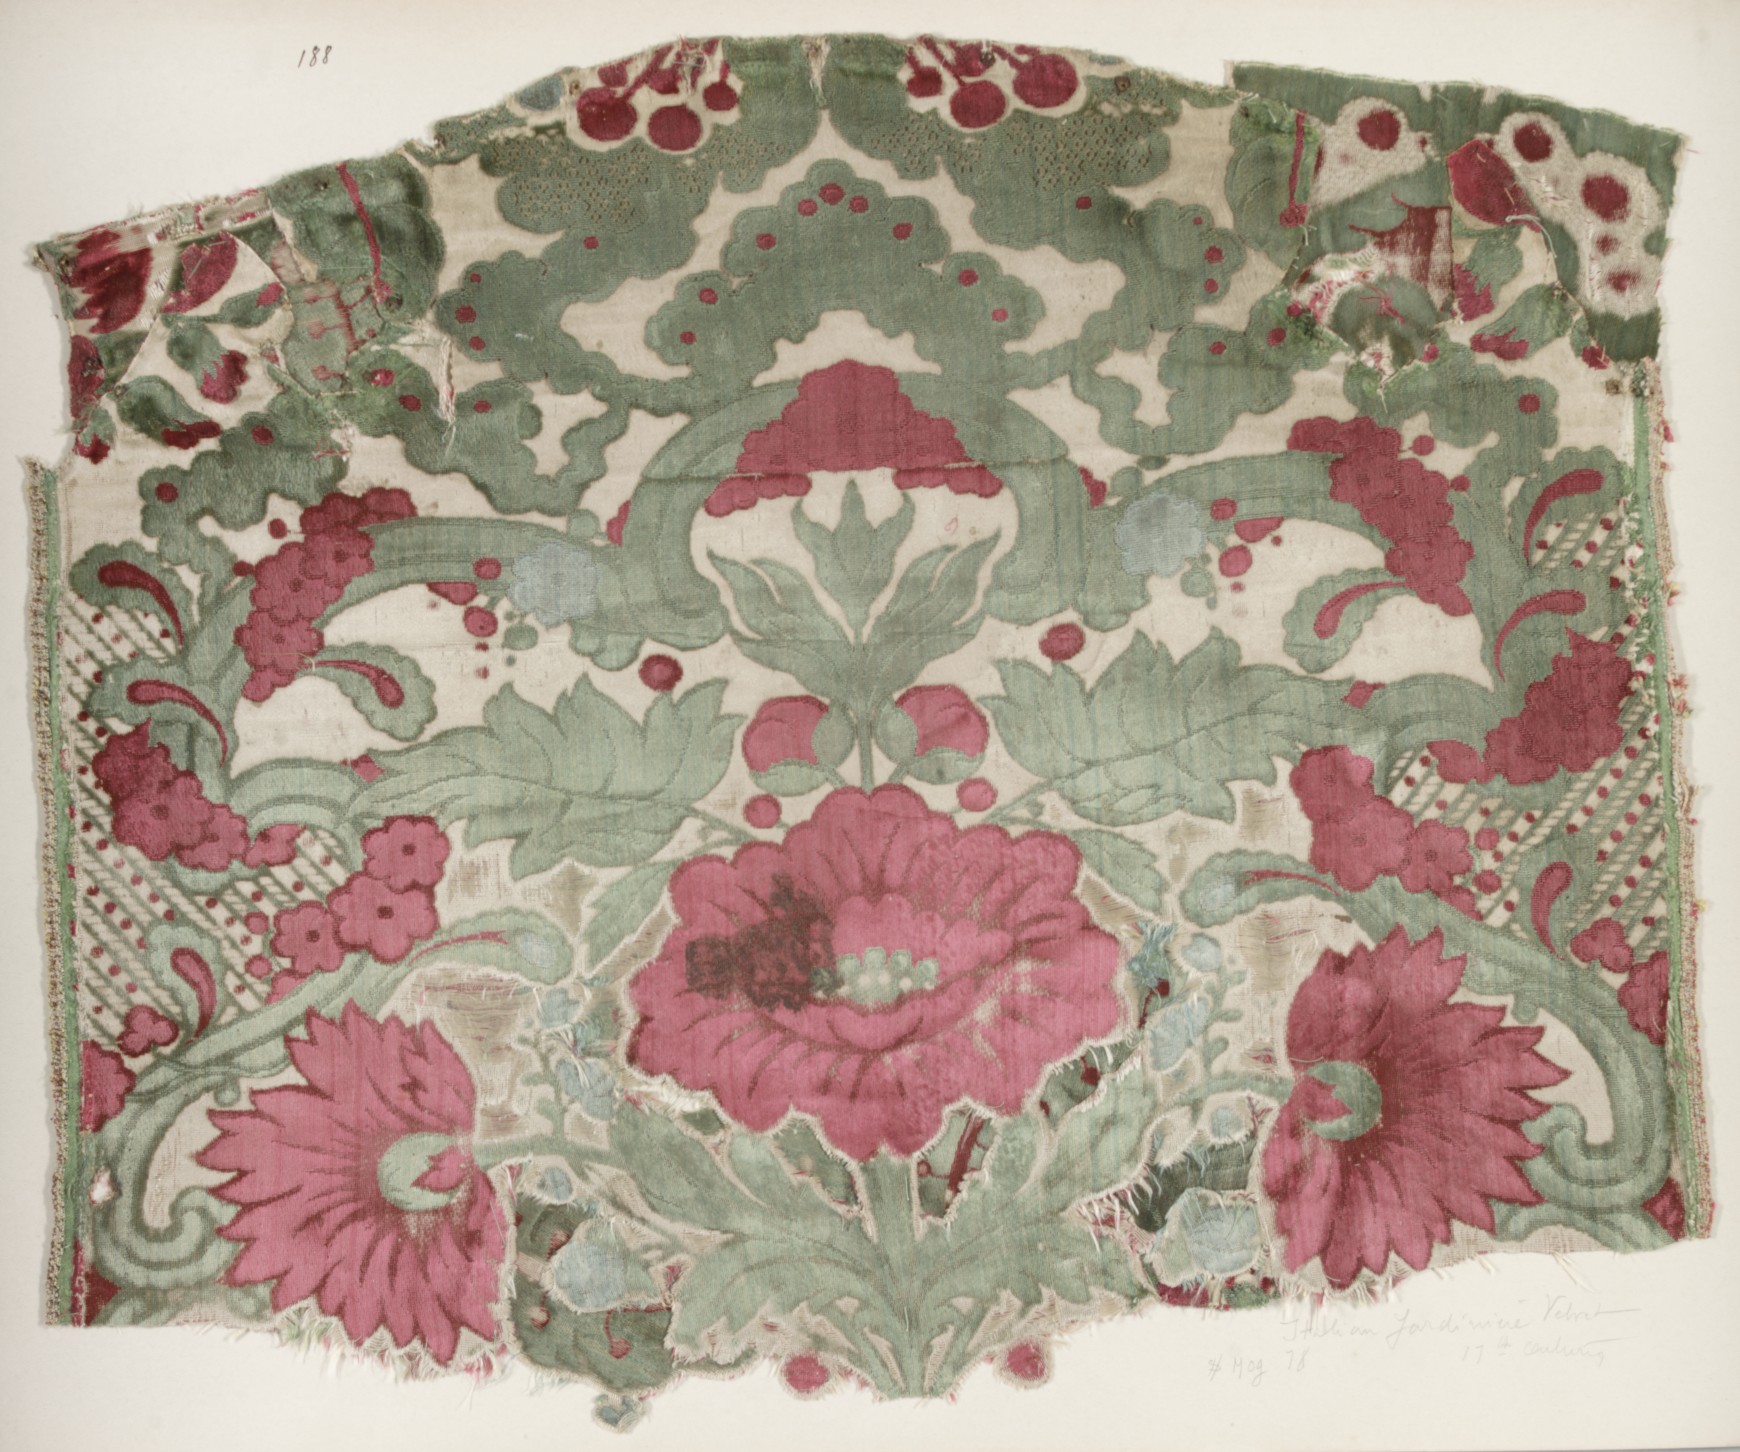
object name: fragment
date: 1601-1700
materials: silk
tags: flowers,leaves